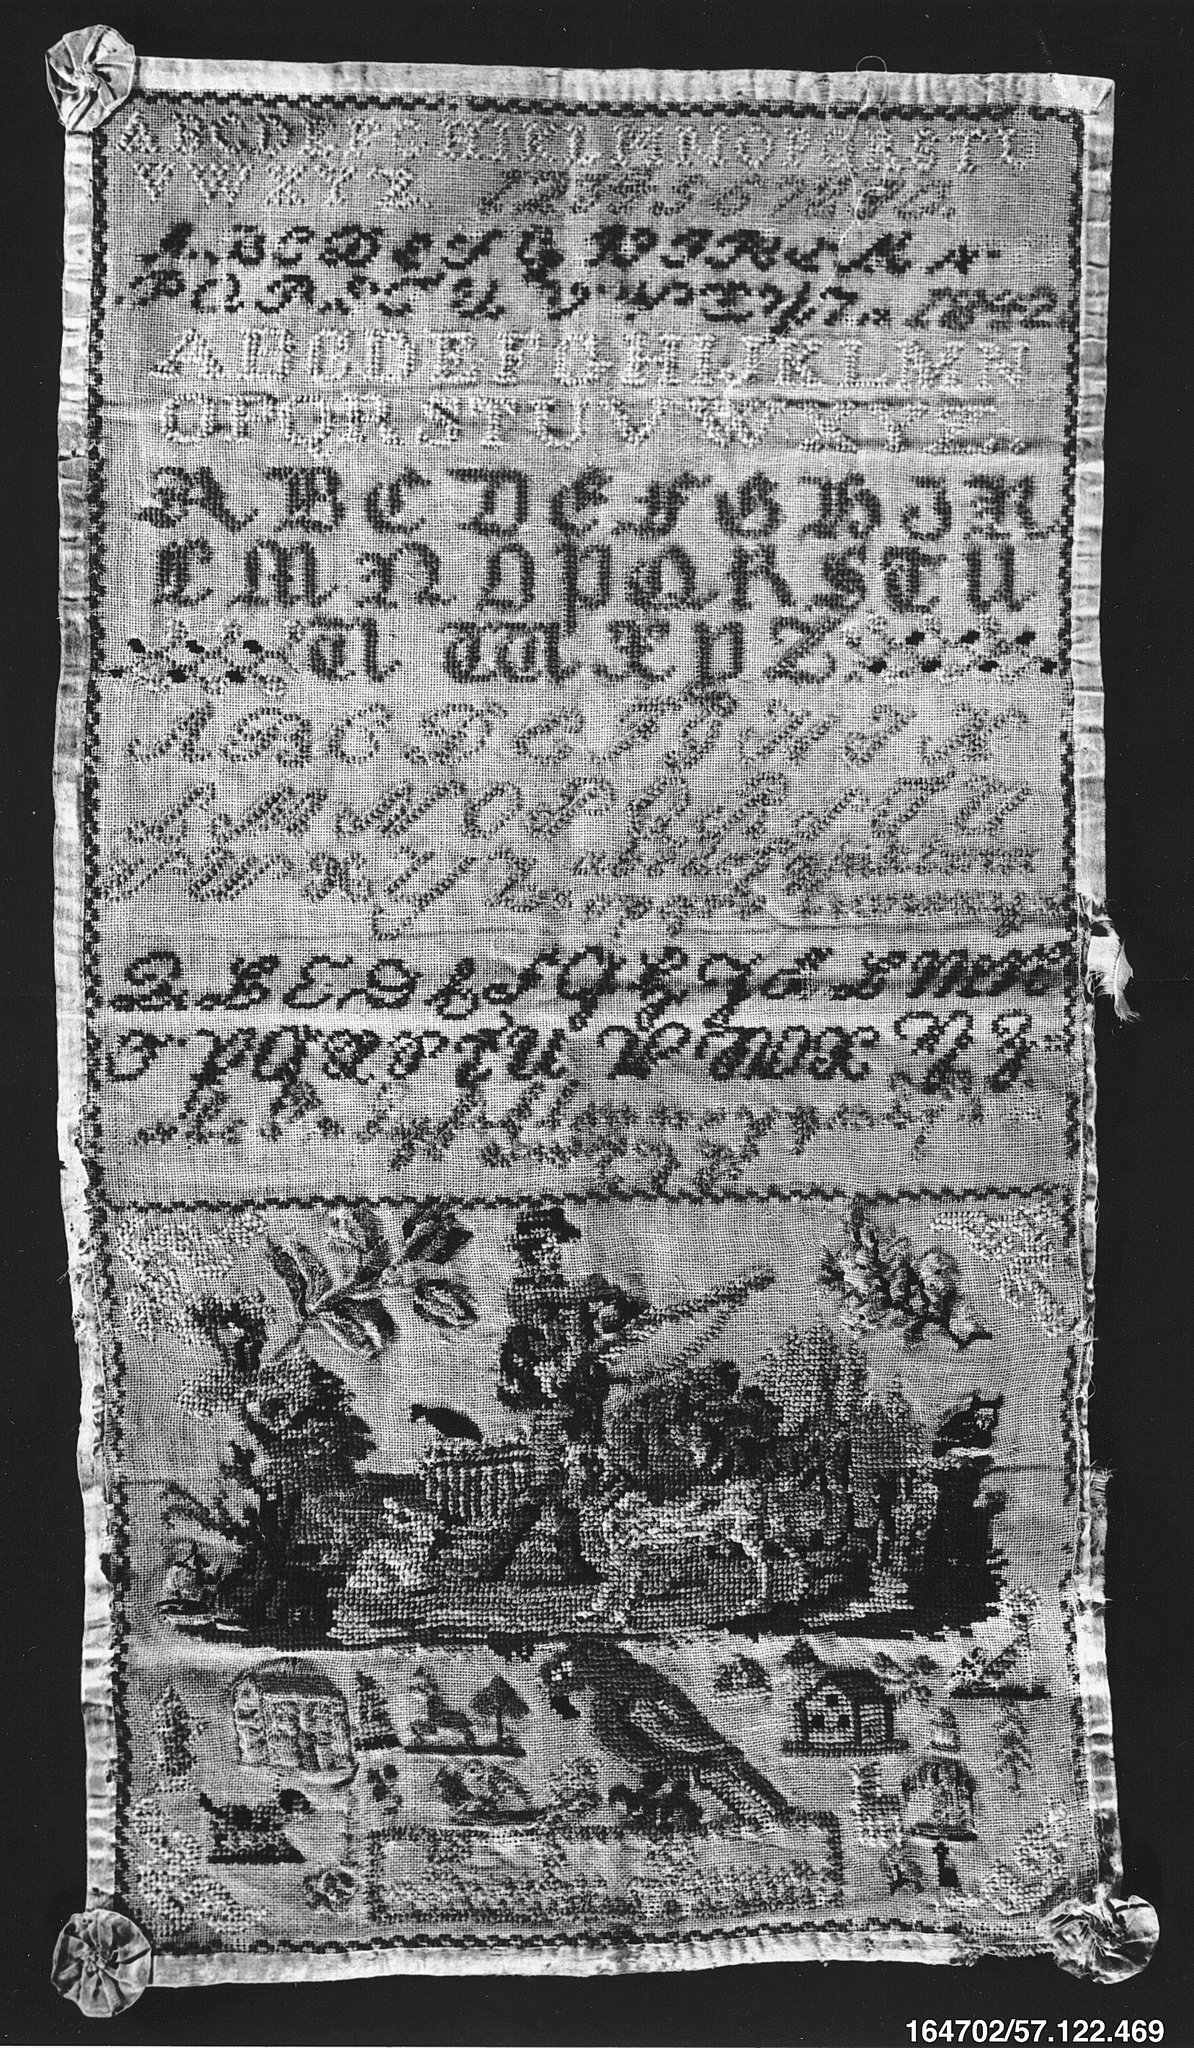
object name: sampler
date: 1842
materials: canvas, wool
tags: human figures,birds,dogs